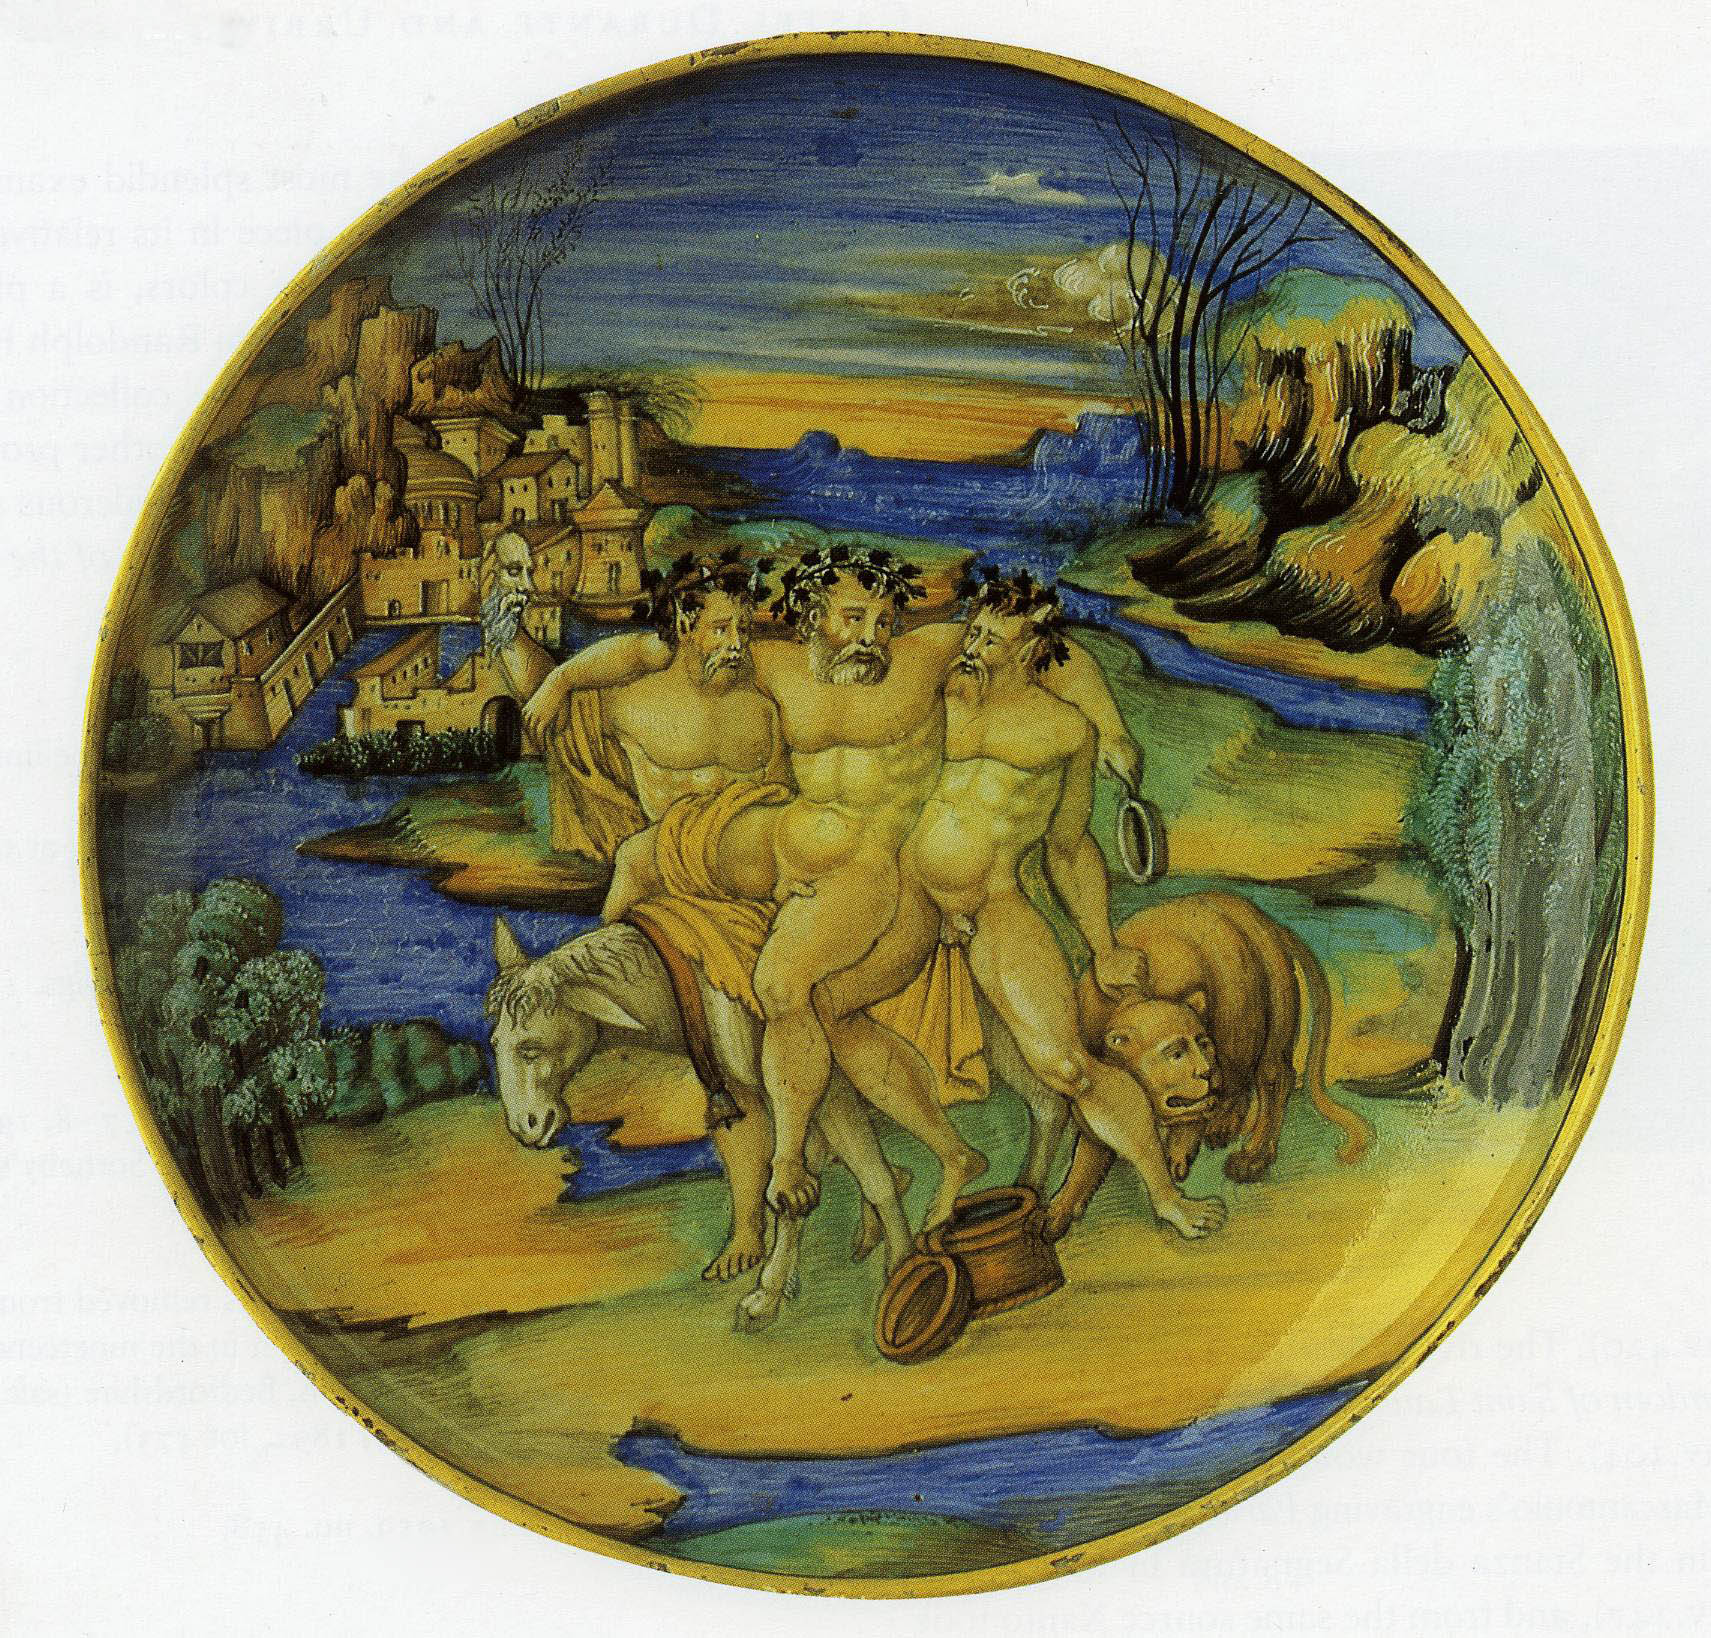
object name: dish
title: Dish (coppa): The satyr Silenus on an Ass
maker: the "milan marsyas" painter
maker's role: artist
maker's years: 1500-1550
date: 1530-1535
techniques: maiolica, glazing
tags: silenus,satyrs,donkeys